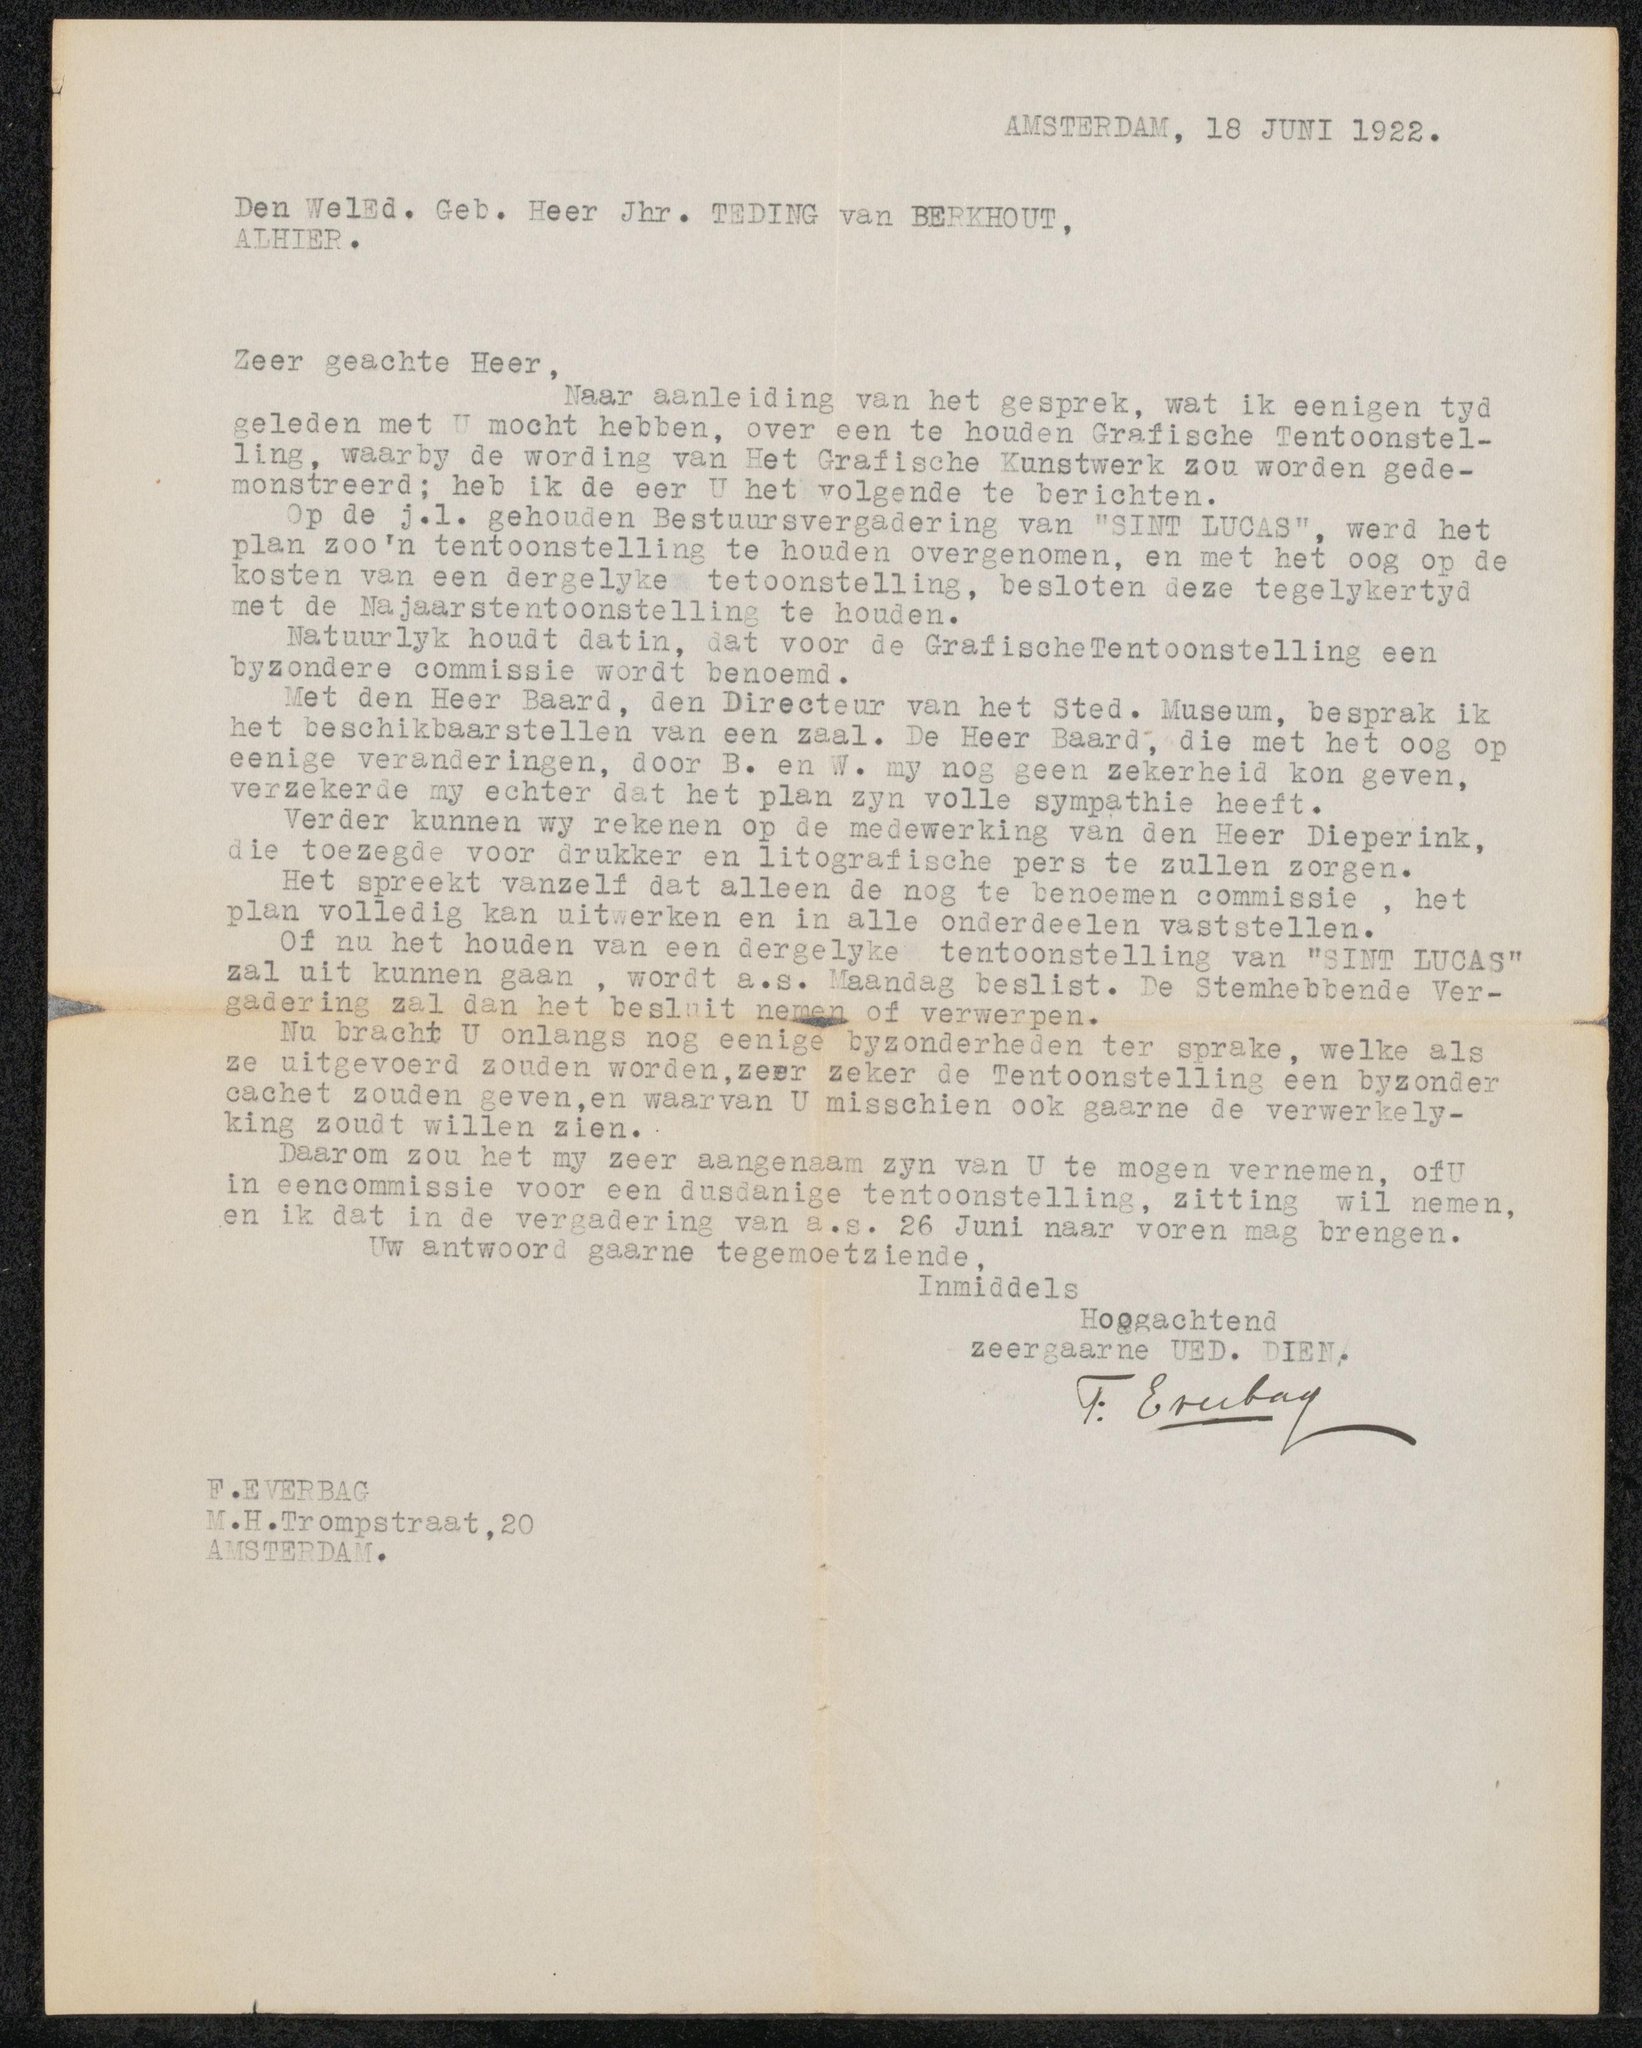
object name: letter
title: Brief aan jonkheer Hendrik Teding van Berkhout (1879-1969)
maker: frans everbag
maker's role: draughtsman, print maker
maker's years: 1877-1947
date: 1922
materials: ink, paper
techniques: pen, typewriting, writing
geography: amsterdam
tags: painter, print maker, herman bernard dieperink, delft, cornelis wilhelmus hyginus baard, haarlem, amsterdam, jonkheer hendrik teding van berkhout (1879-1969), exhibition ~ art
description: Brief bevat opgave biografische data van Frans Everbag.